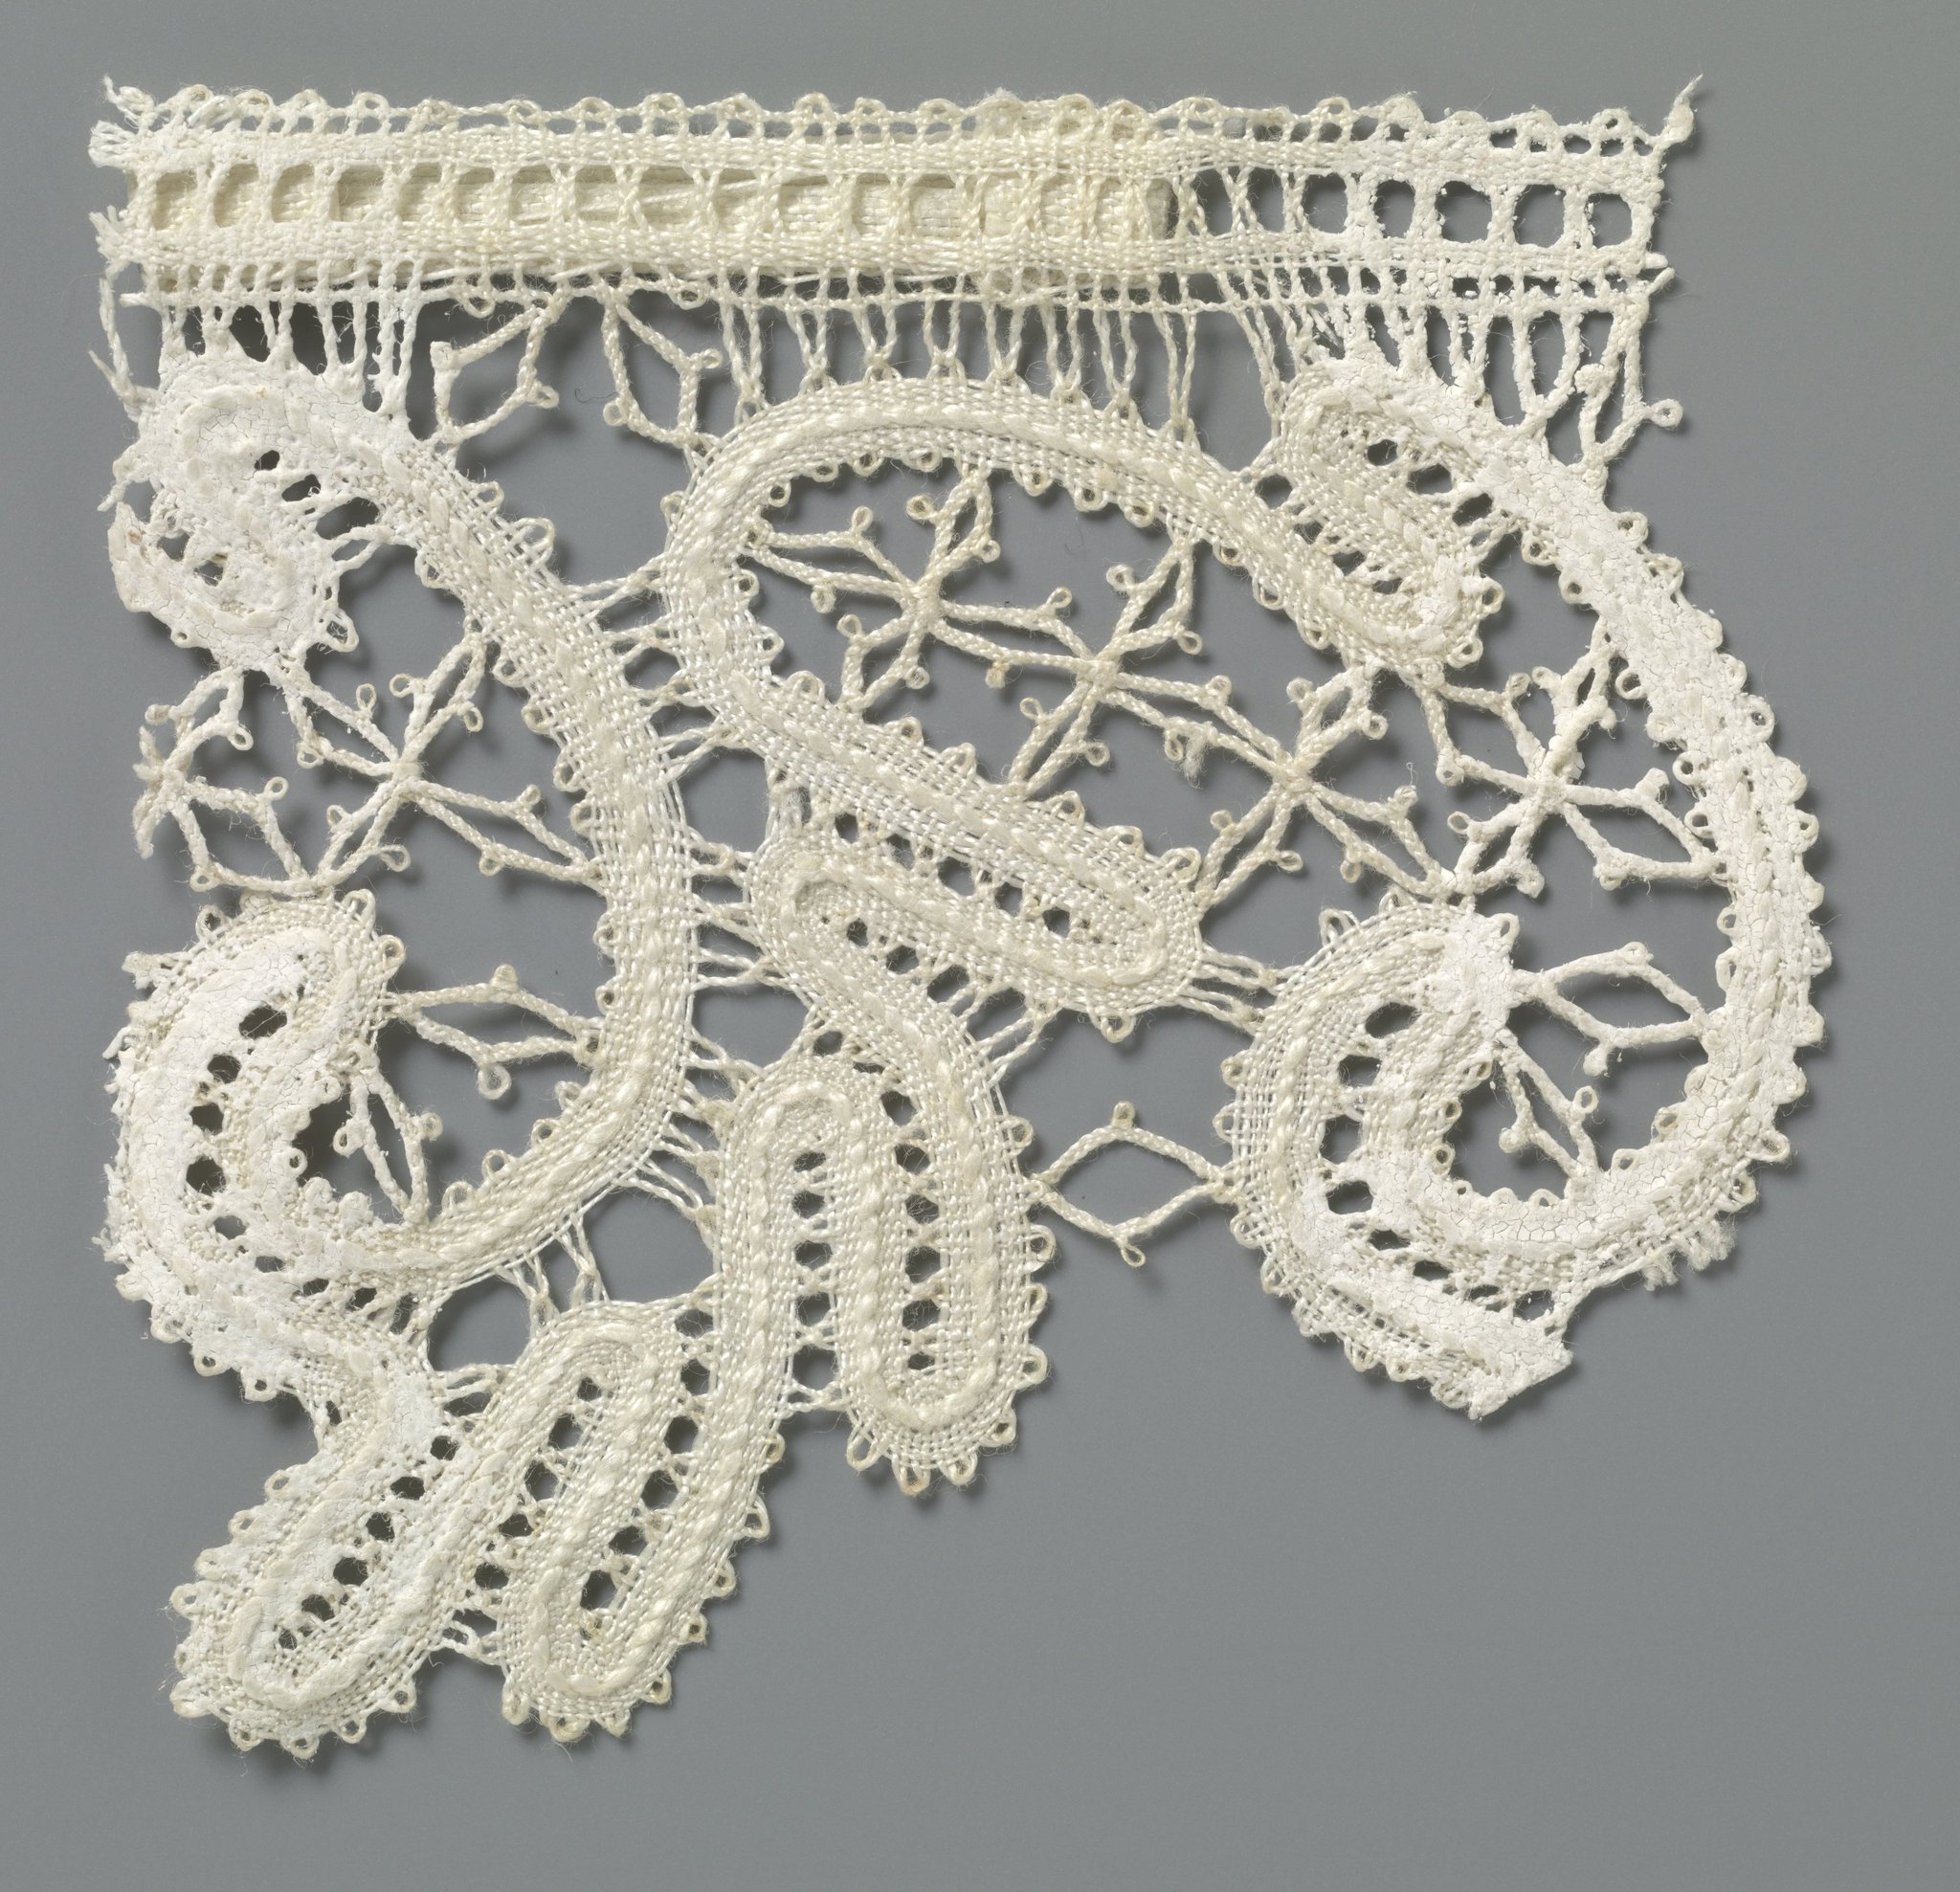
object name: strip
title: Strook kloskant met slingerend lint in grote bochten en smalle lobben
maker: Anonymous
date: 1900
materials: linen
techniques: lace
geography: russia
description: Strook naturelkleurige kloskant, Russische kant. Het patroon wordt gevormd een slingerend lint, dat afwisselend grote bochten en diepe smalle lobben vormt. Het lint is gemaakt in dichtgewerkte linnenslag, met opengewerkte randen. Reliëfcontouren worden gevormd door een vlechtje dat over het midden van het lint loopt. Het patroon wordt door een siergrond in vorm gehouden en bestaat uit vierpuntige sterren en ruiten, gemaakt met gepicoteerde vlechtjes. De bovenzijde is recht afgewerkt en voorzien van picots. De schulpen langs de onderzijde zijn ook afgewerkt met picots.